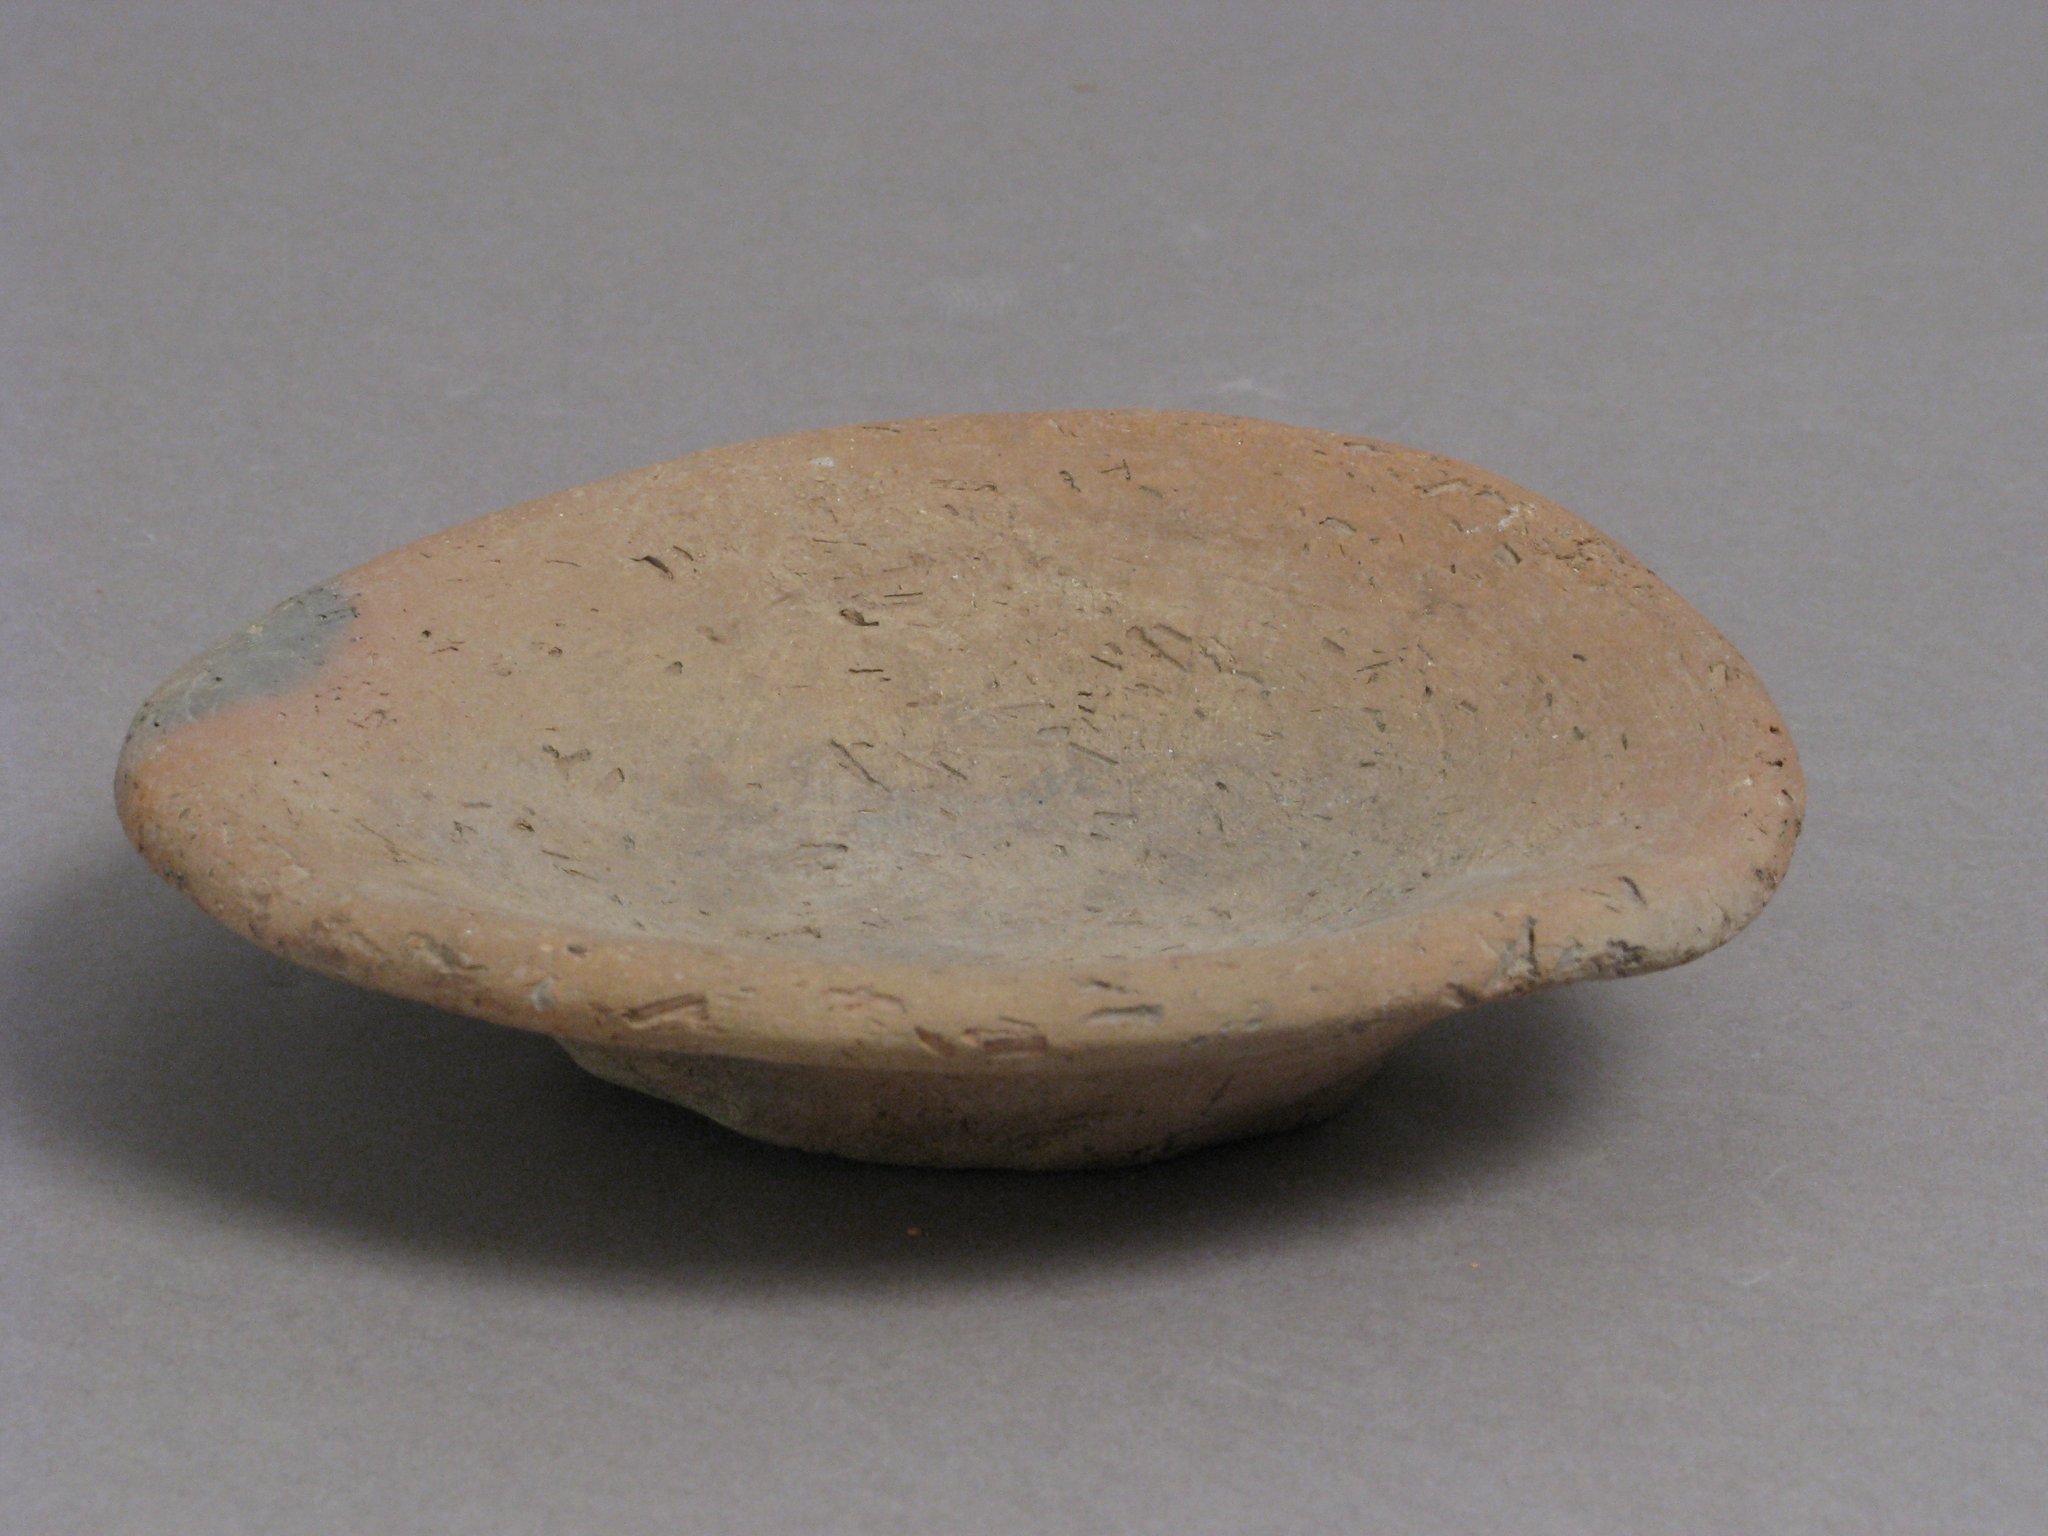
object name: dish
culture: coptic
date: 301-700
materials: earthenware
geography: egypt